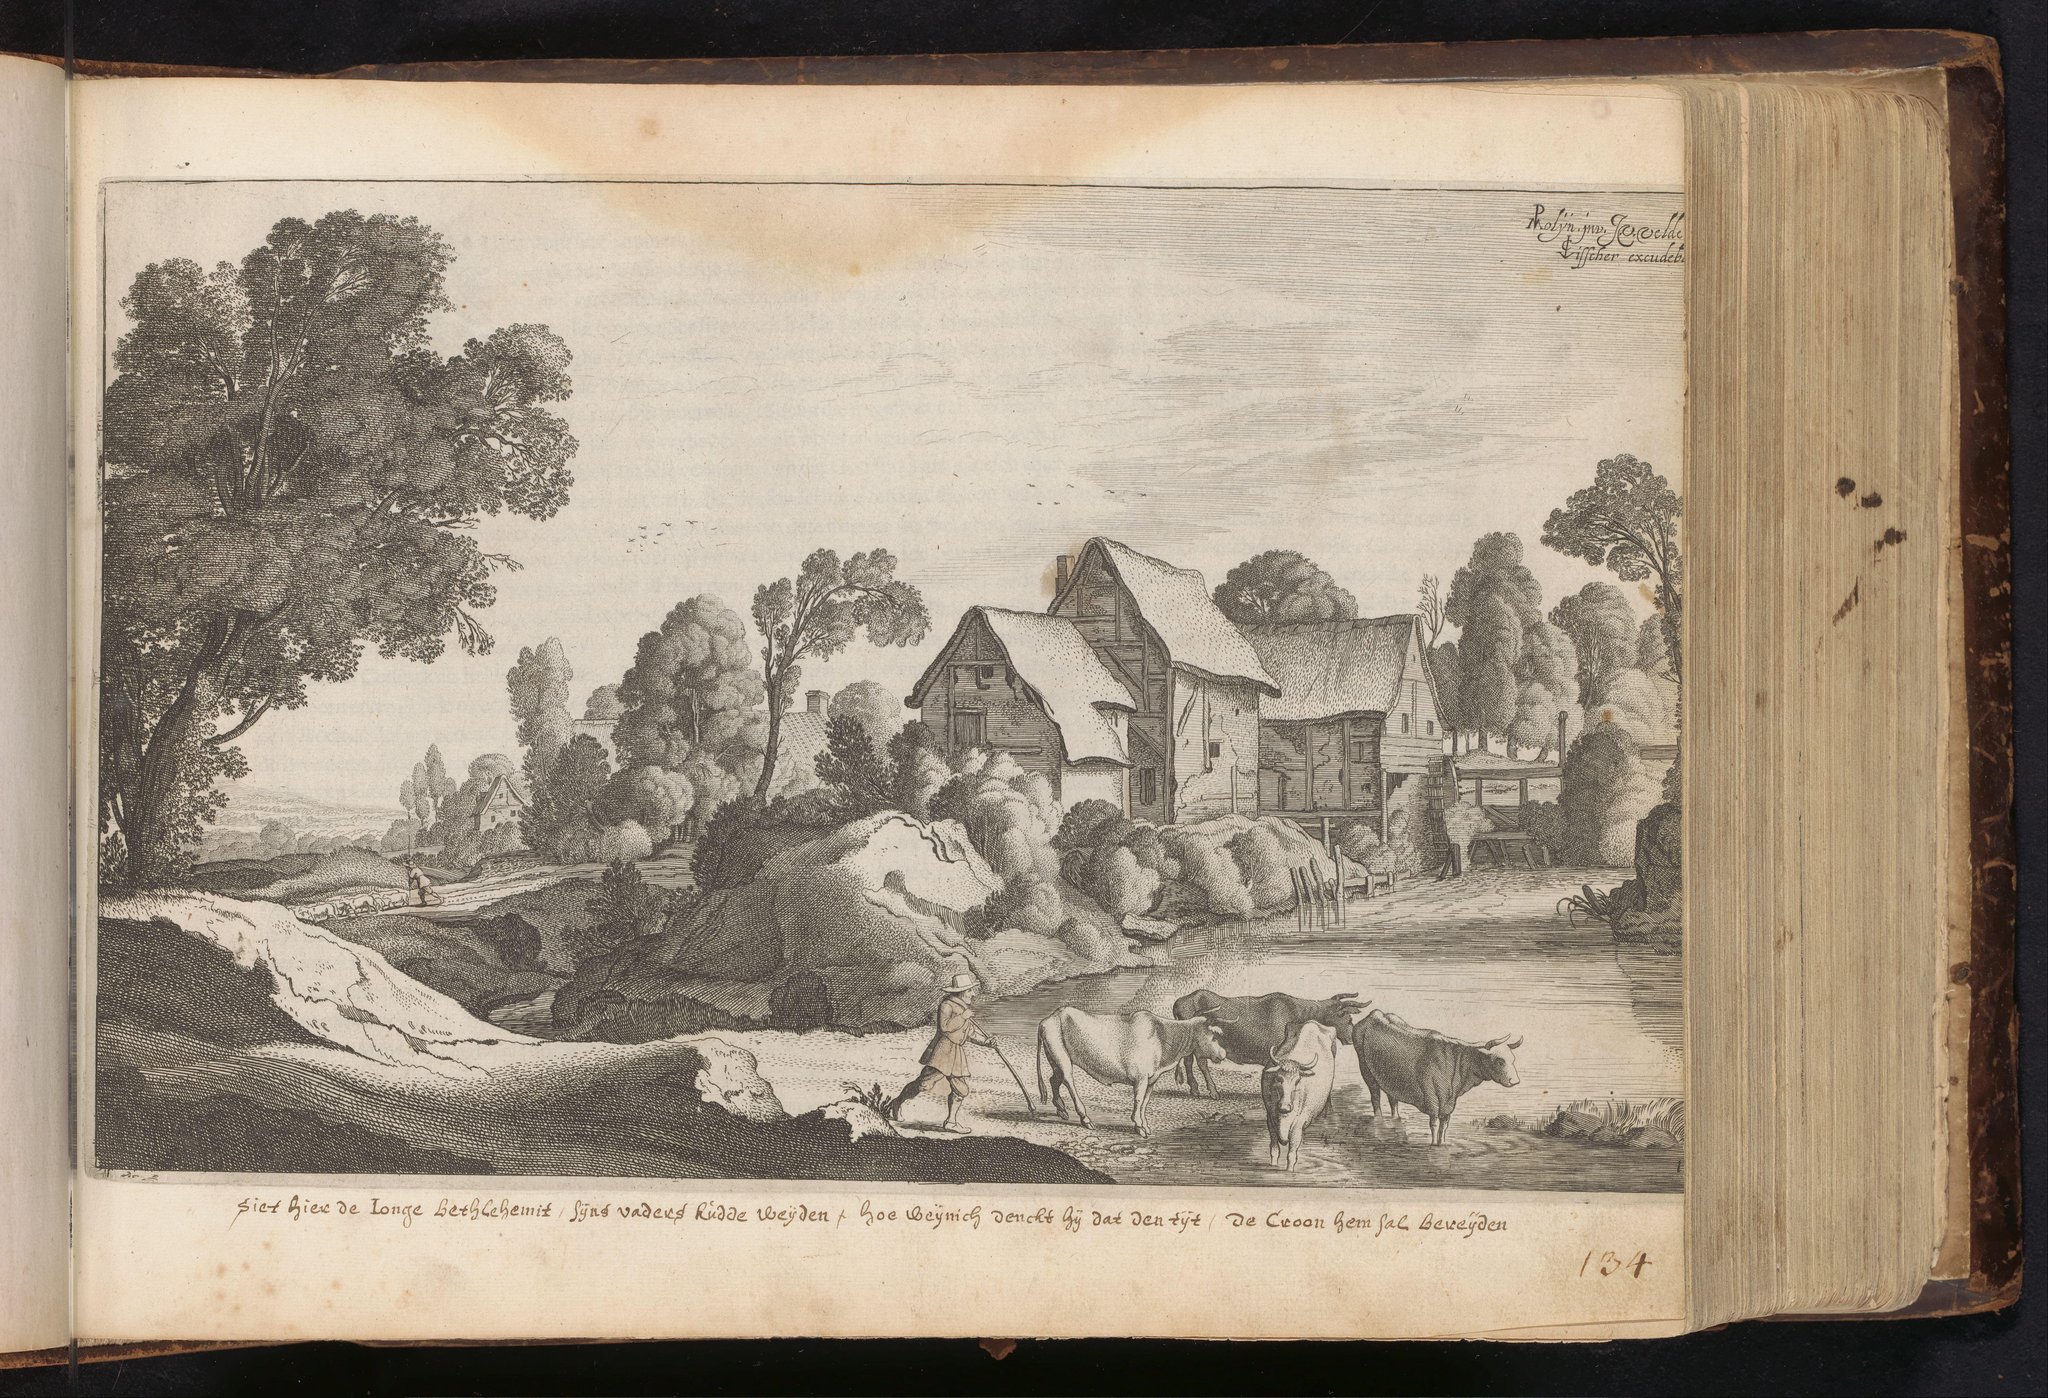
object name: album leaf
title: Herder met koeien bij een watermolen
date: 1604-1641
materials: paper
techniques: etching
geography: amsterdam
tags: cow, ford, david as shepherd, cattle driving, cattle driver, watermill in landscape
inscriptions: inscription: ‘siet hier de Ionge bethlehemit / sijns vaders kudde weijden / hoe weijnich denckt hij dat den tijt / de Croon hem sal bevreijden’, number: ‘133’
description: Herder met koeien bij een doorwaadbare plaats bij een watermolen in een landschap. Op de achtergrond een herder met een kudde schapen. In de context van het album en volgens het onderschrift wordt de herder geïnterpreteerd als David. Deze prent maakt deel uit van een album.